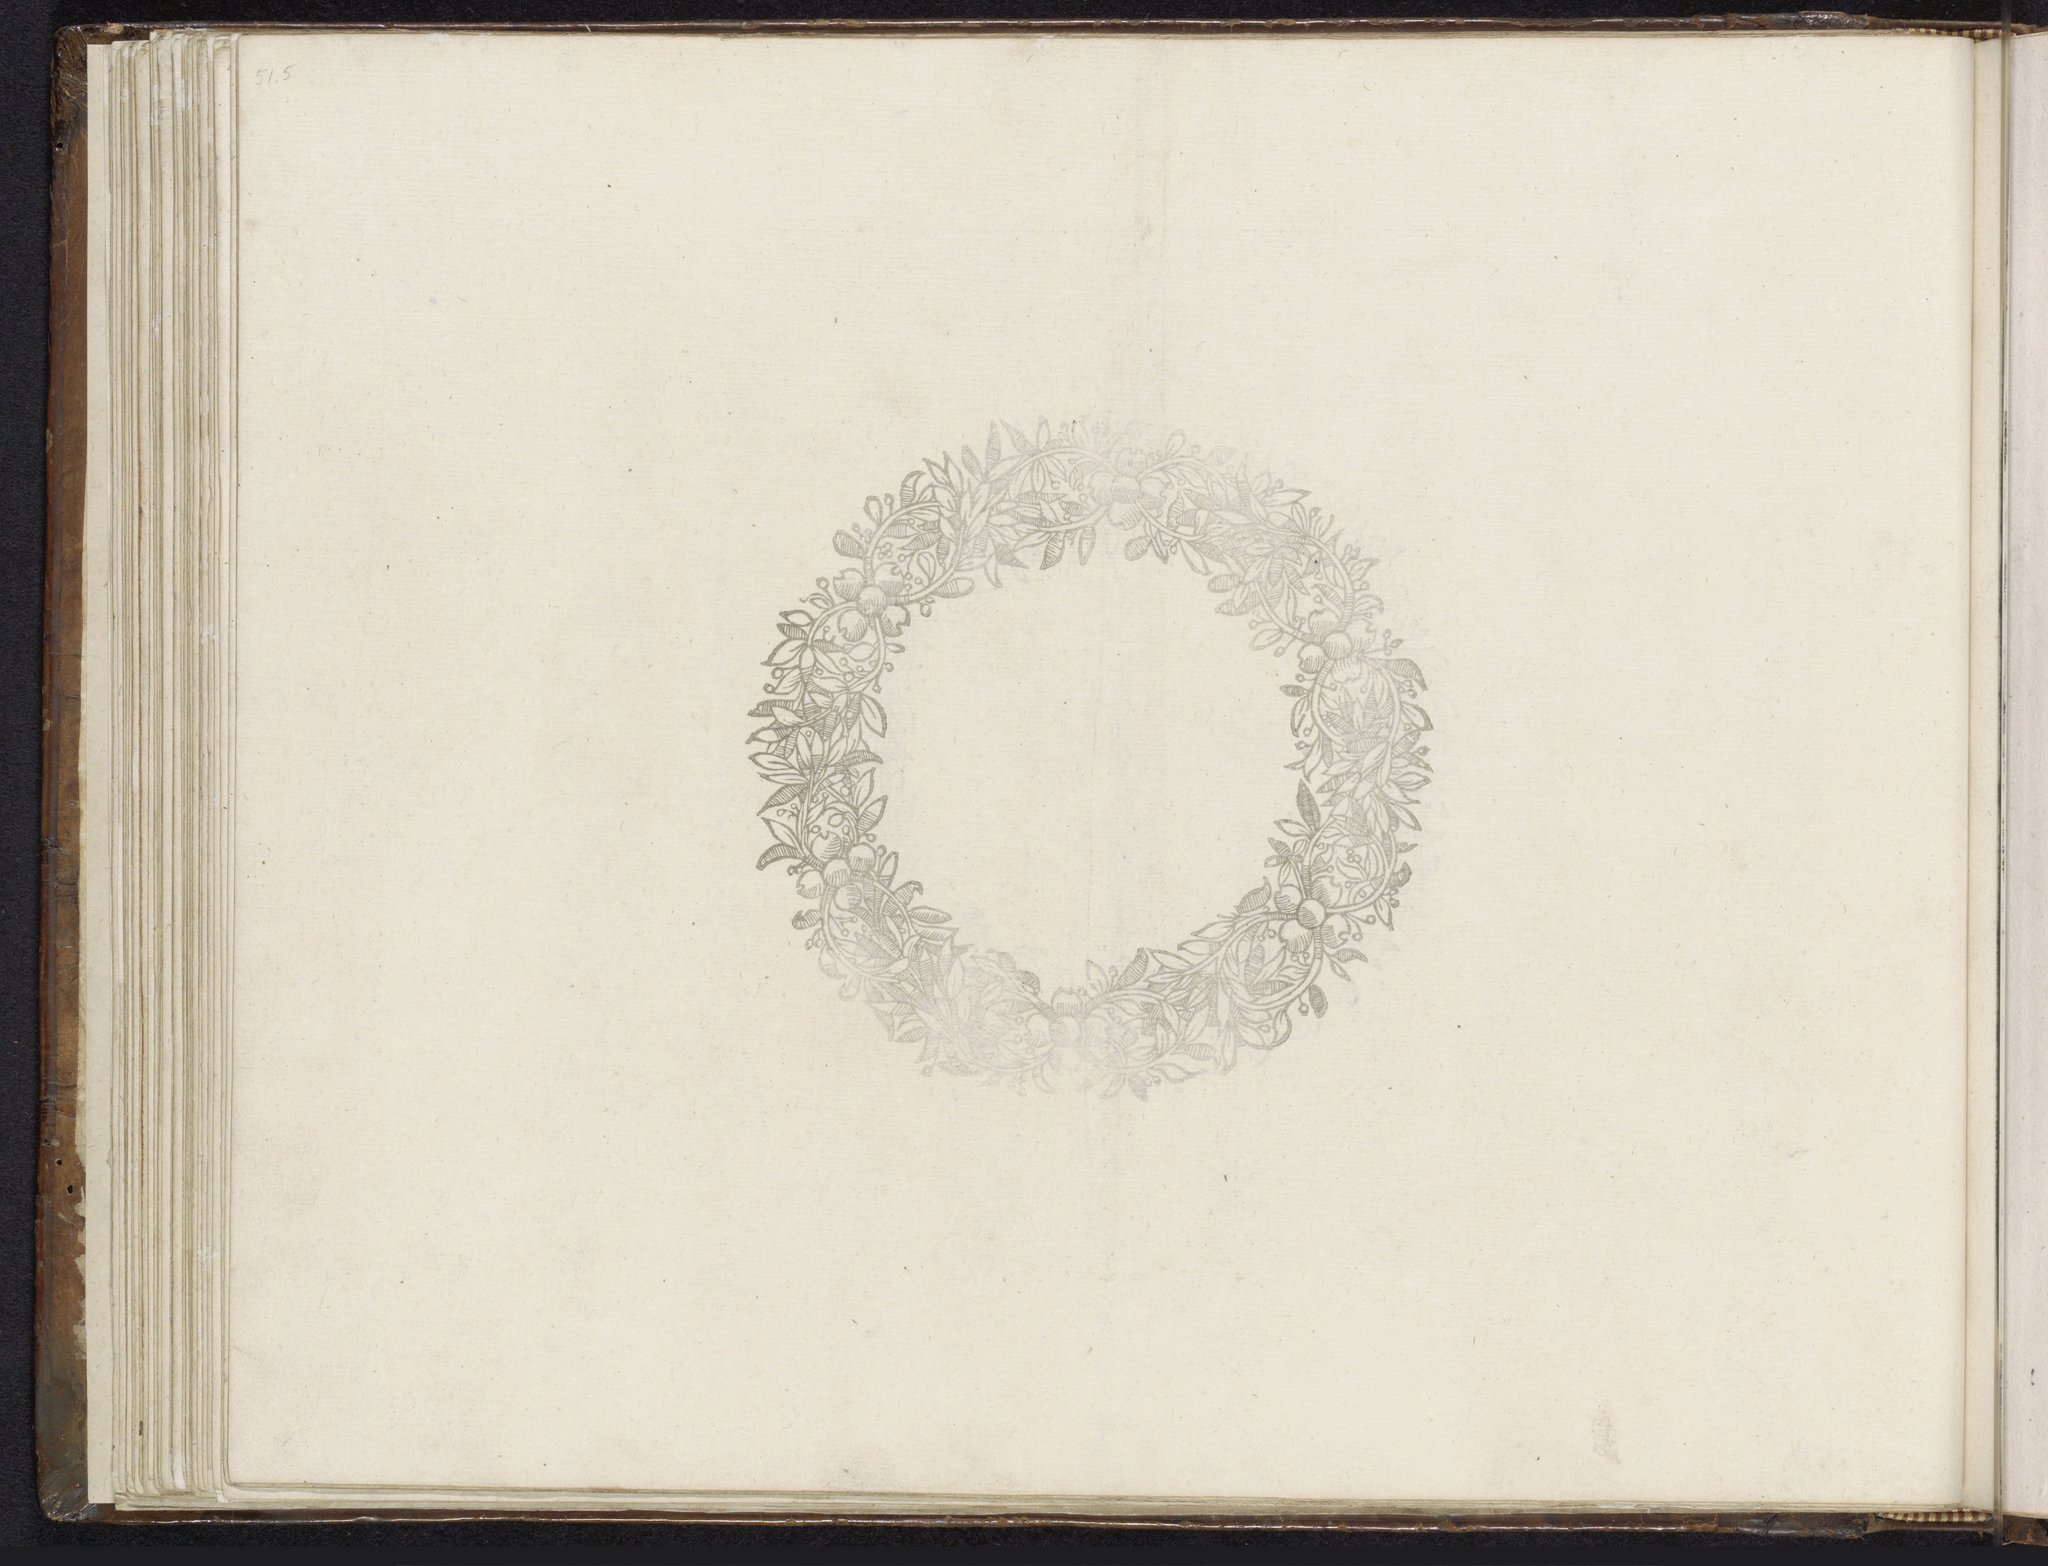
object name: print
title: Thesaurus sacrarum historiaru[m] veteris testame[n]ti, elega[n]tissimis imaginibus expressu[m] excelle[n]tissimoru[m] in hac arte viroru[m] opera: nu[n]c primu[m] in luce[m] editus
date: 1579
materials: paper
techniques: printmaking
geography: antwerp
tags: garland, wreath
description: Ornamentele bloemenkrans. Prent maakt deel uit van een album.